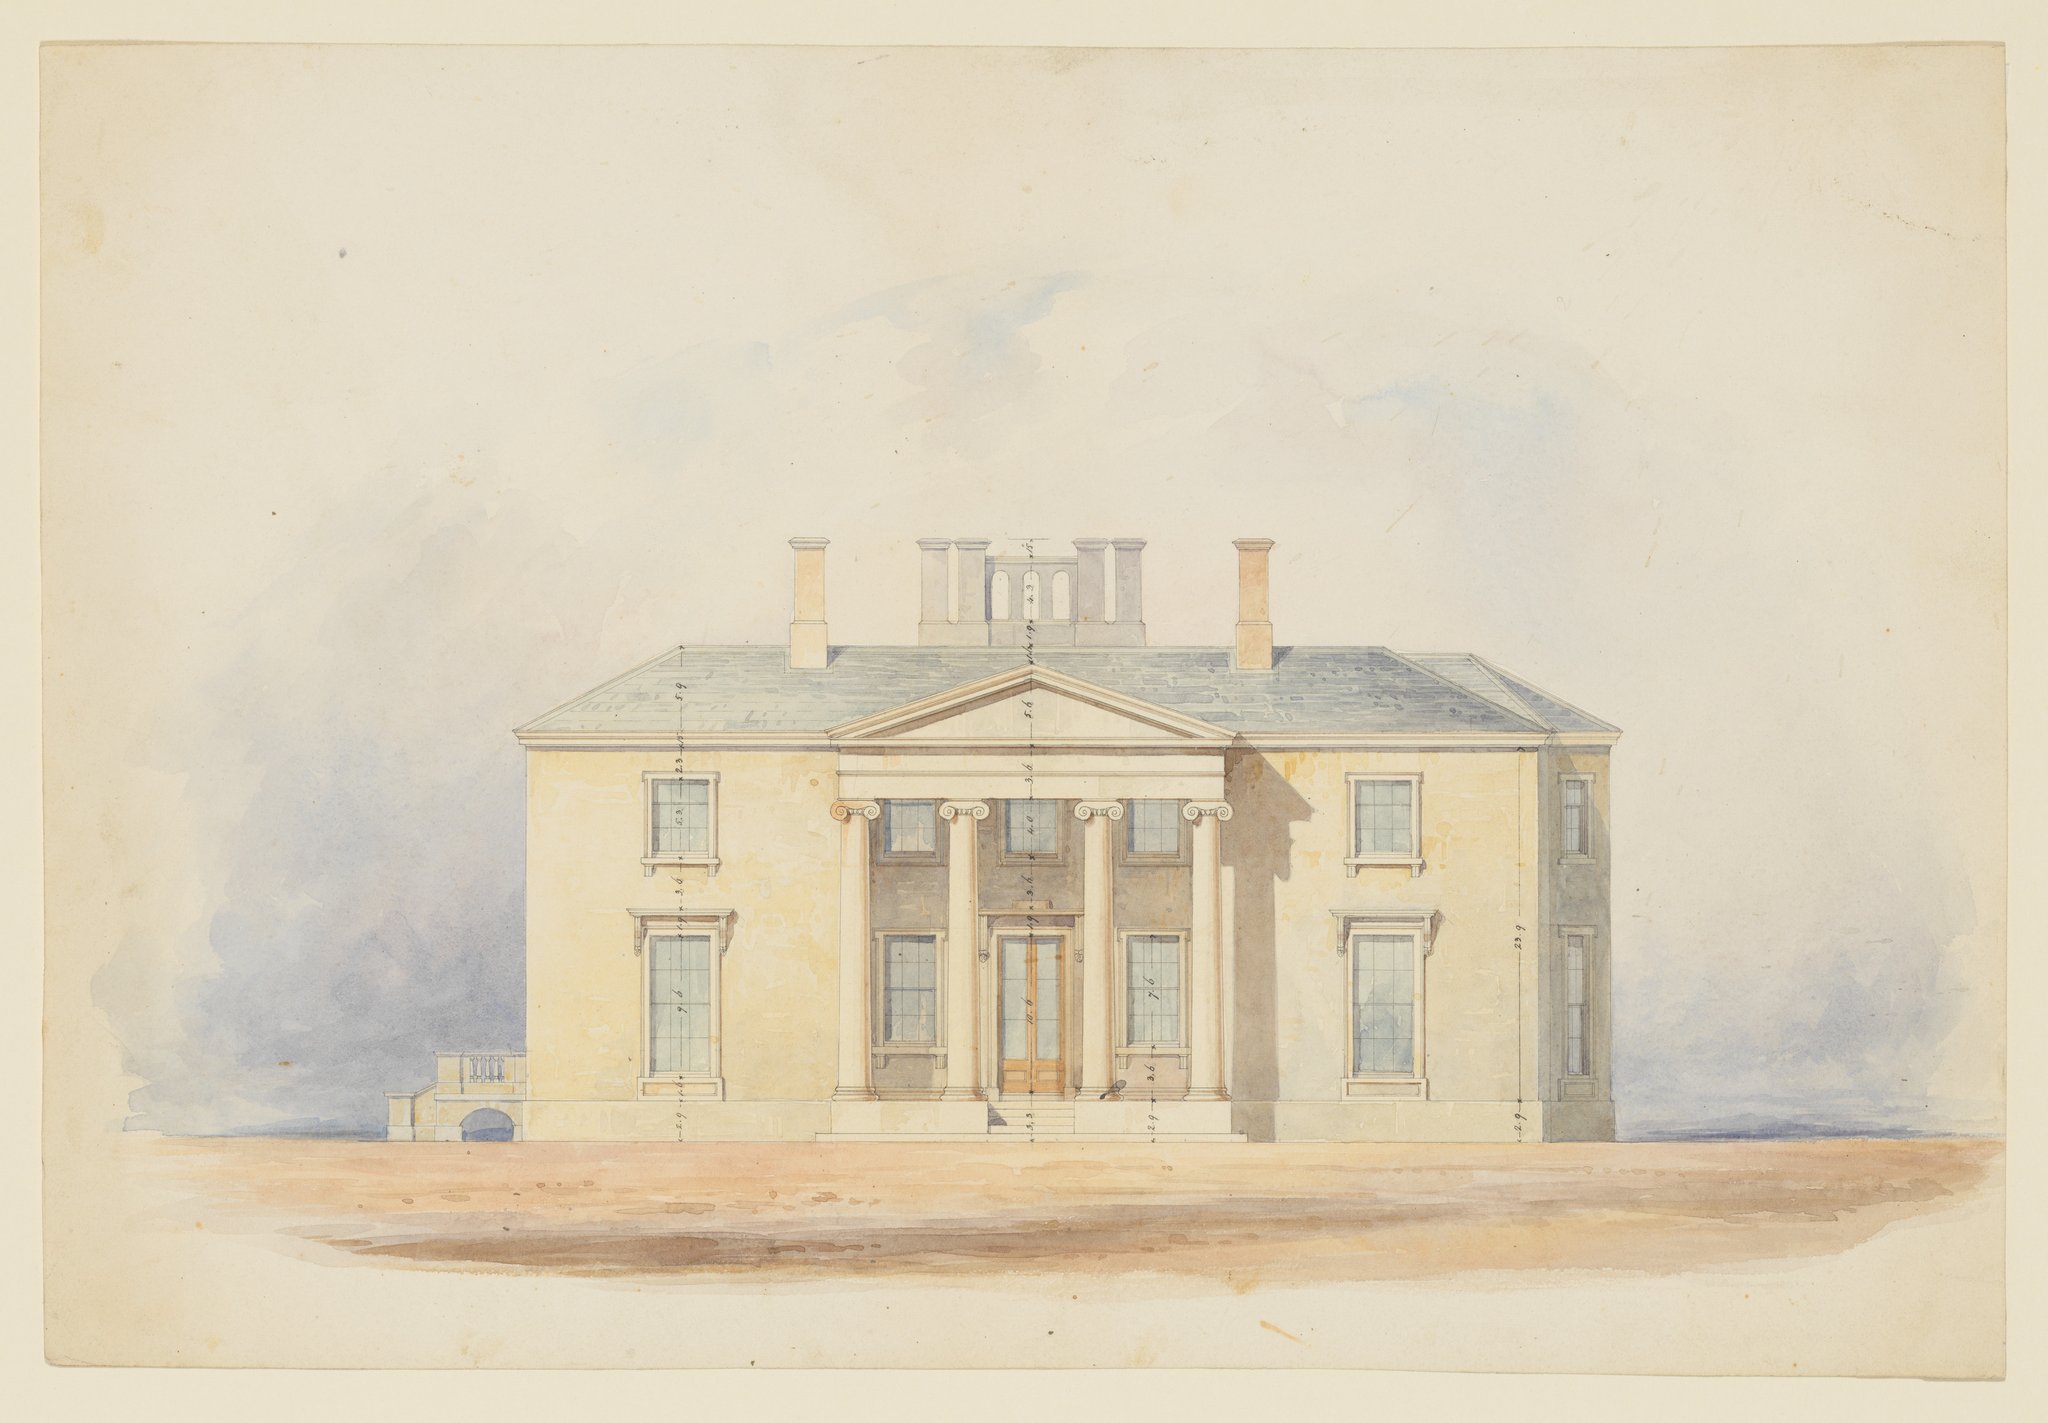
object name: drawing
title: Design for a Classical Country House, Entrance Elevation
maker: anonymous, british, 19th century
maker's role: artist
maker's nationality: british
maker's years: 1800-1900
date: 1801-1833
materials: ink, watercolor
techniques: pen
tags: architecture,houses